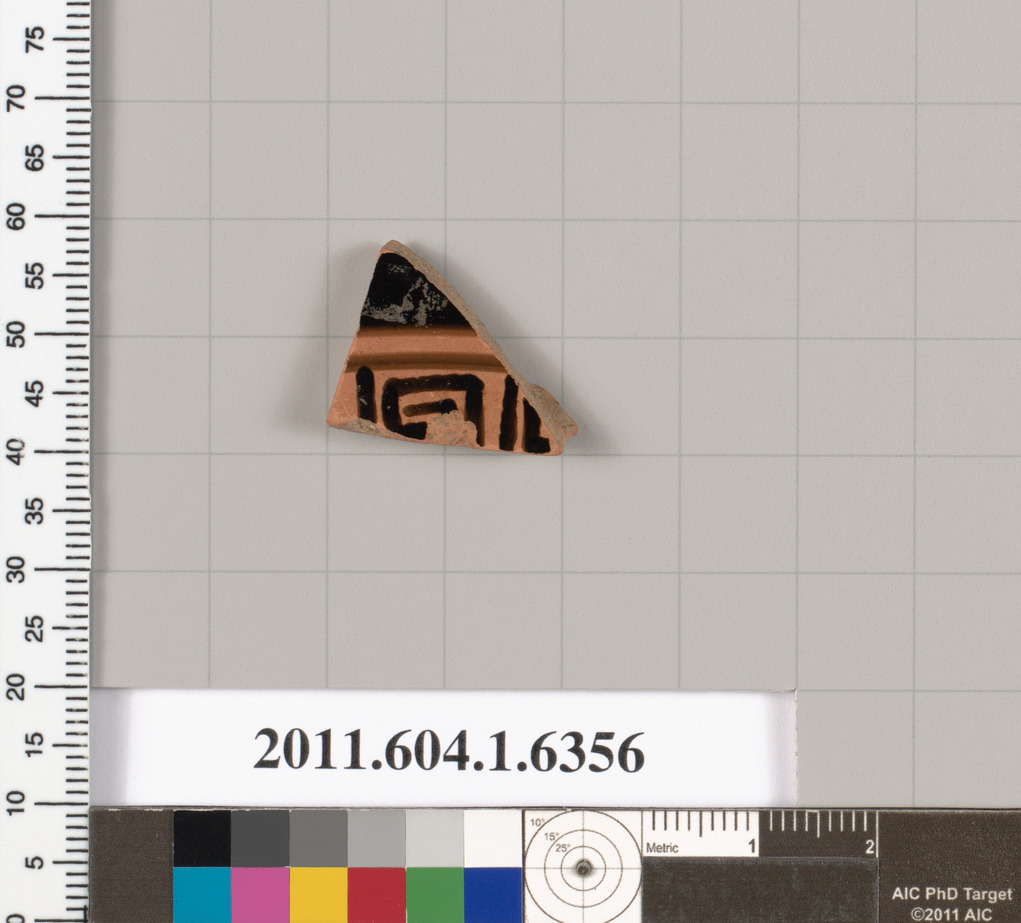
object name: kylix fragment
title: Terracotta fragment of a kylix (drinking cup)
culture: greek, attic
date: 500-480 BCE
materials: terracotta